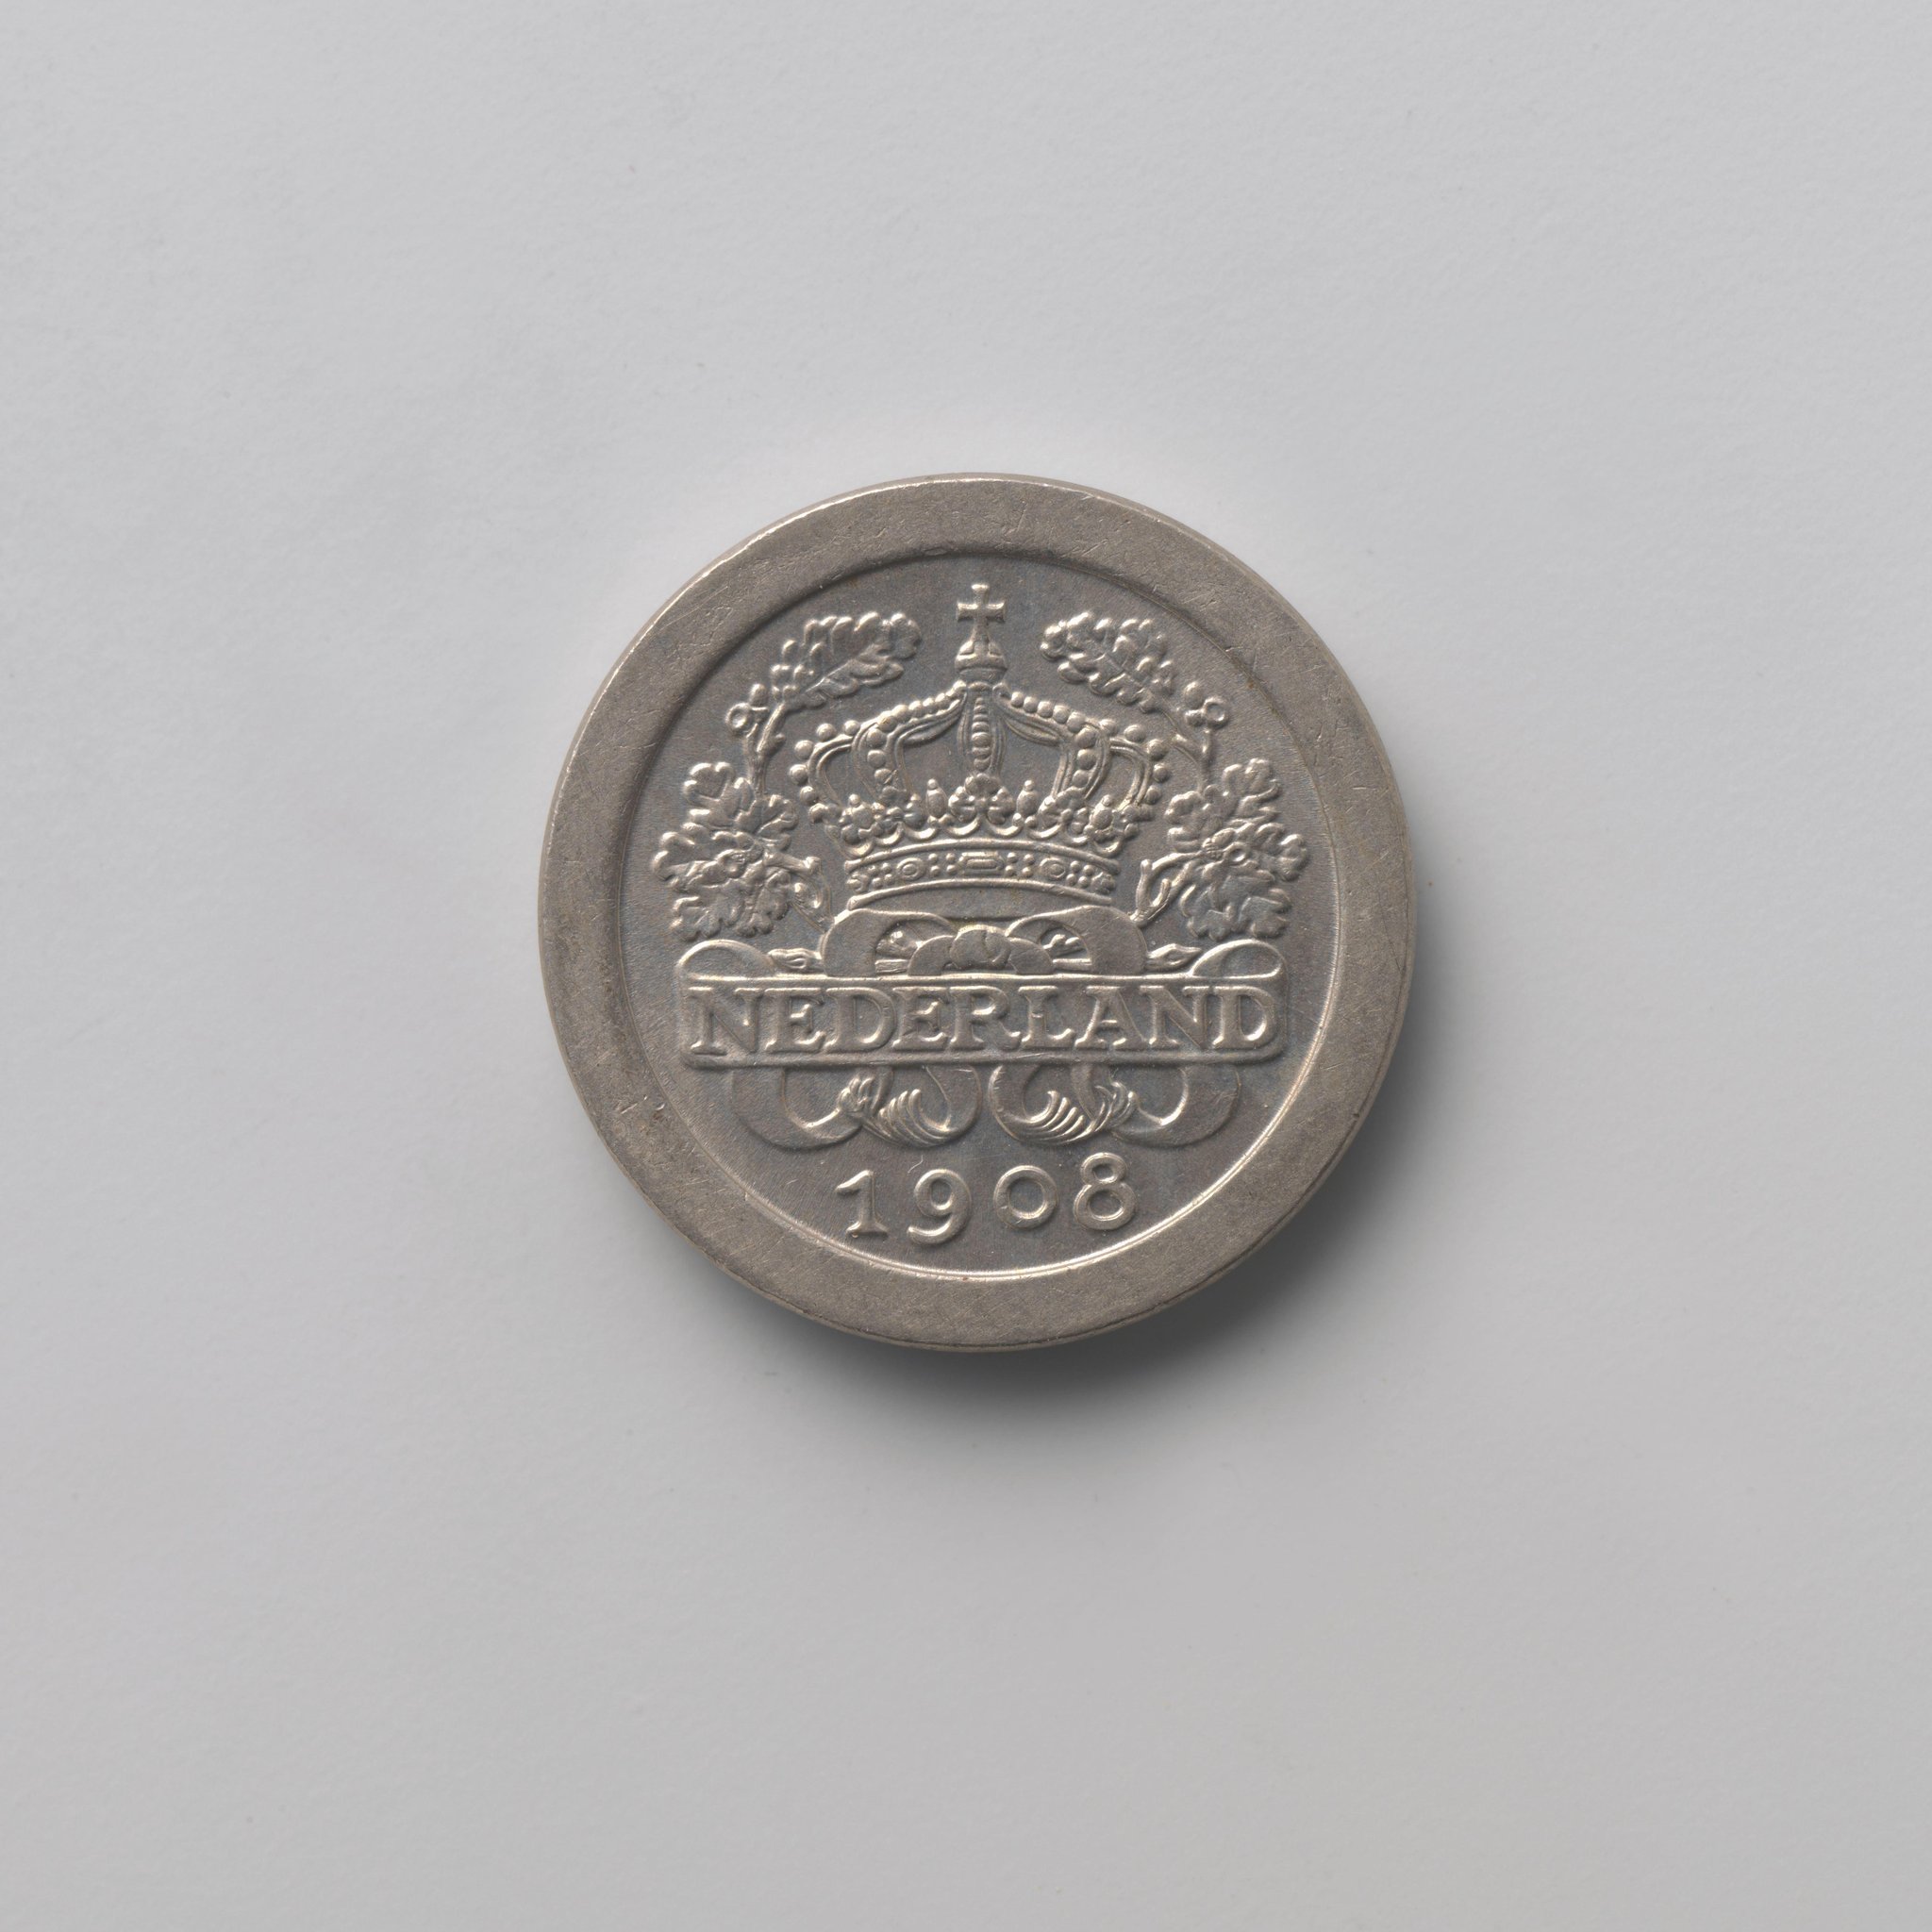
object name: coin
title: Nederland, 5 cent,1908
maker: wilhelmina of the netherlands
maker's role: print maker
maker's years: 1880-1962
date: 1908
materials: nickel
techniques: striking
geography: utrecht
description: Nikkelen munt. Voorzijde: tussen twee eiketakken koninklijke kroon, waaronder banderol met landsaanduiding. Daaronder jaartal. Keerzijde: tussen twee samengebonden oranjetakken waarde-aanduiding 5 cents. Gladde rand.